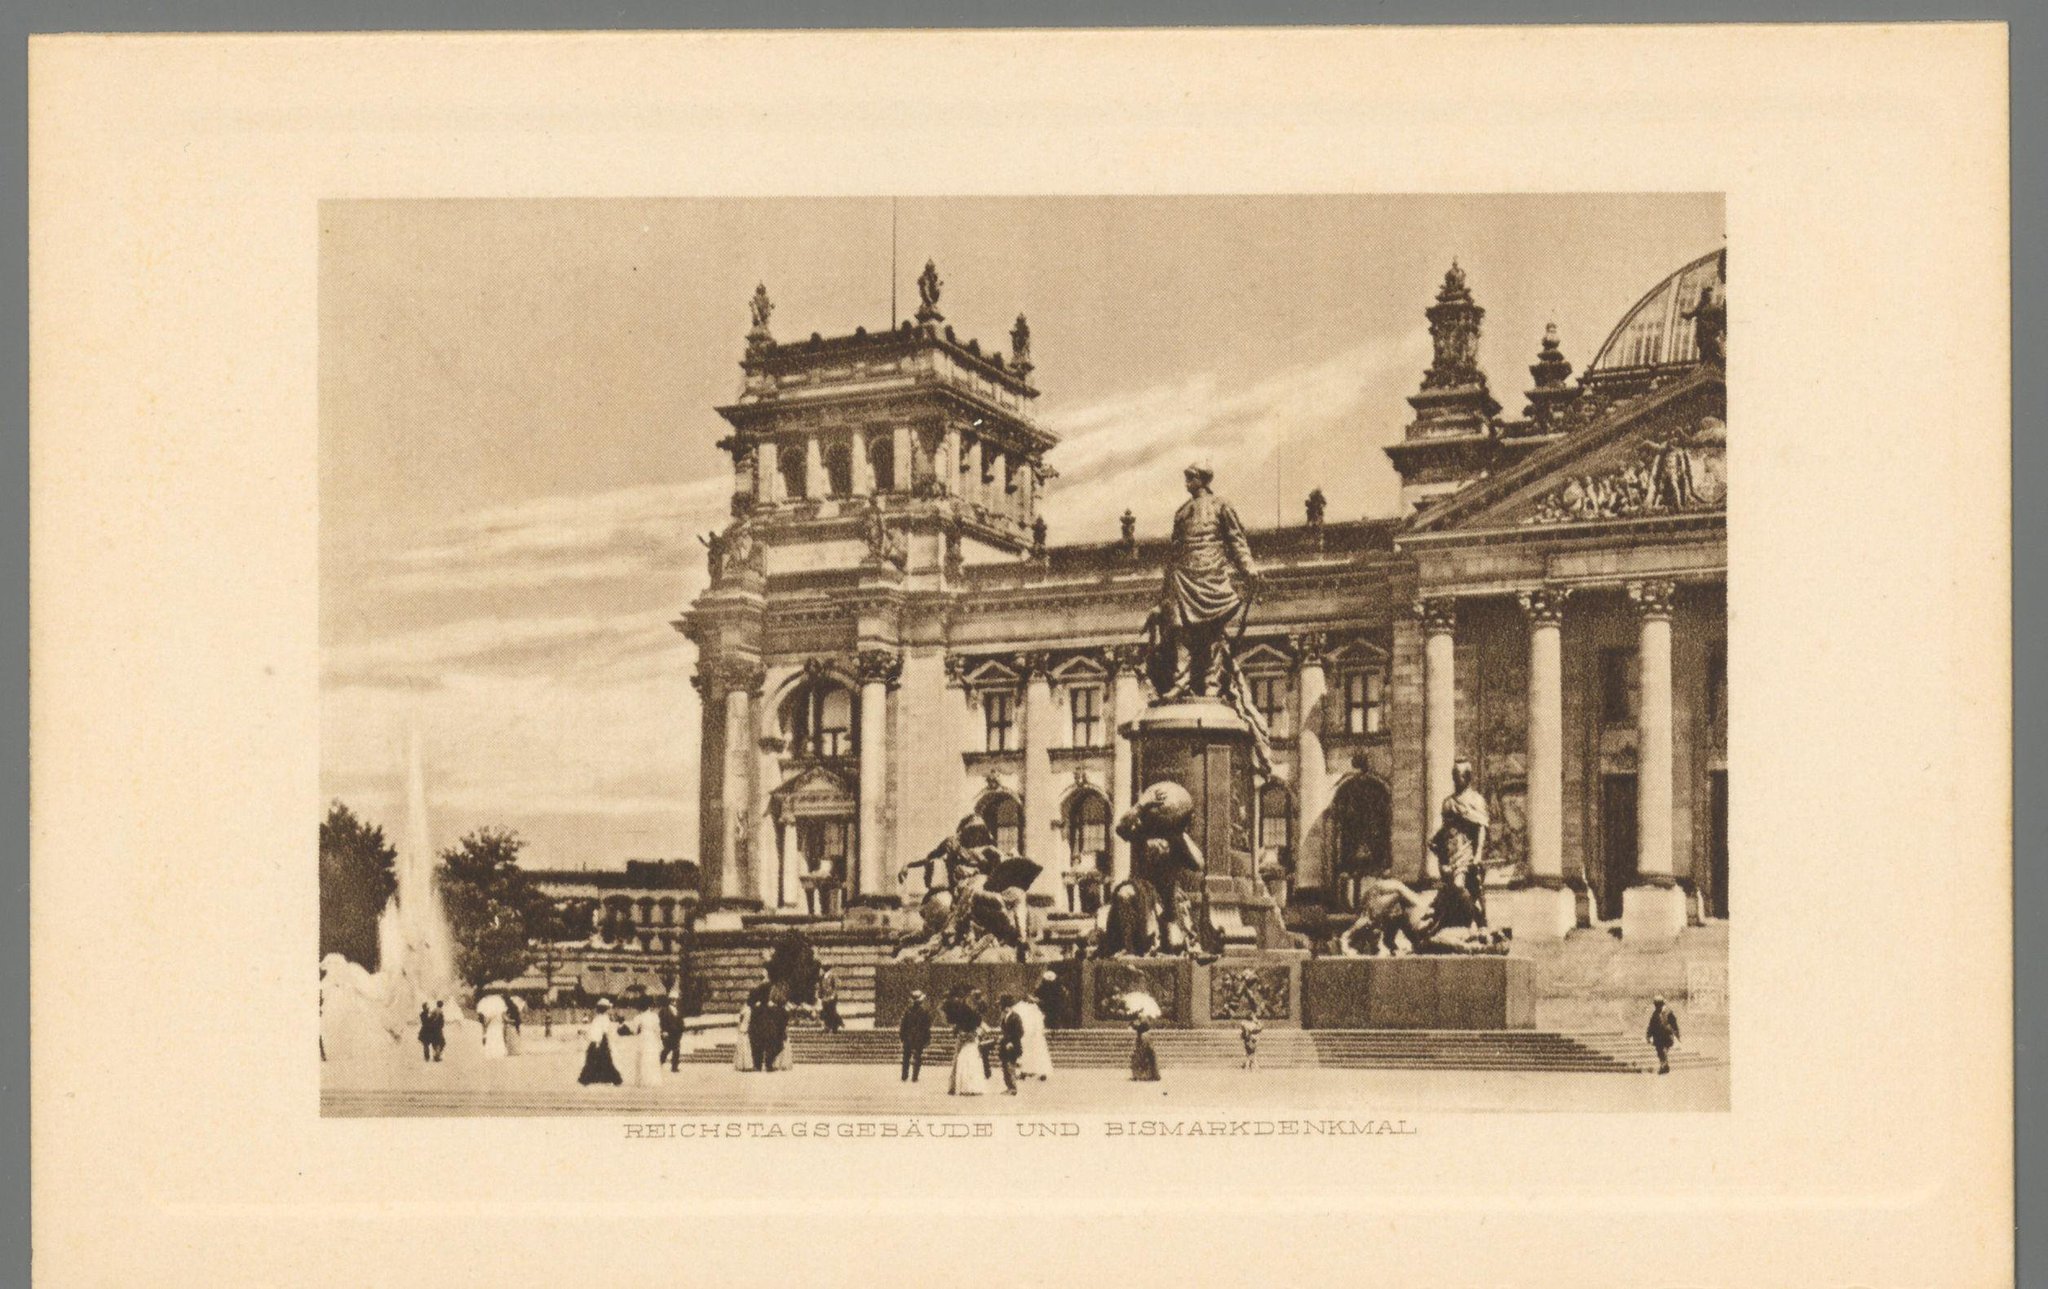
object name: photomechanical print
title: Reichstagsgebäude und Bismarkdenkmal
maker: Anonymous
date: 1905-1909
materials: cardboard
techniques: rotogravure, writing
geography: berlin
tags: berlin, frederik willem iv (koning van pruisen), monument, statue